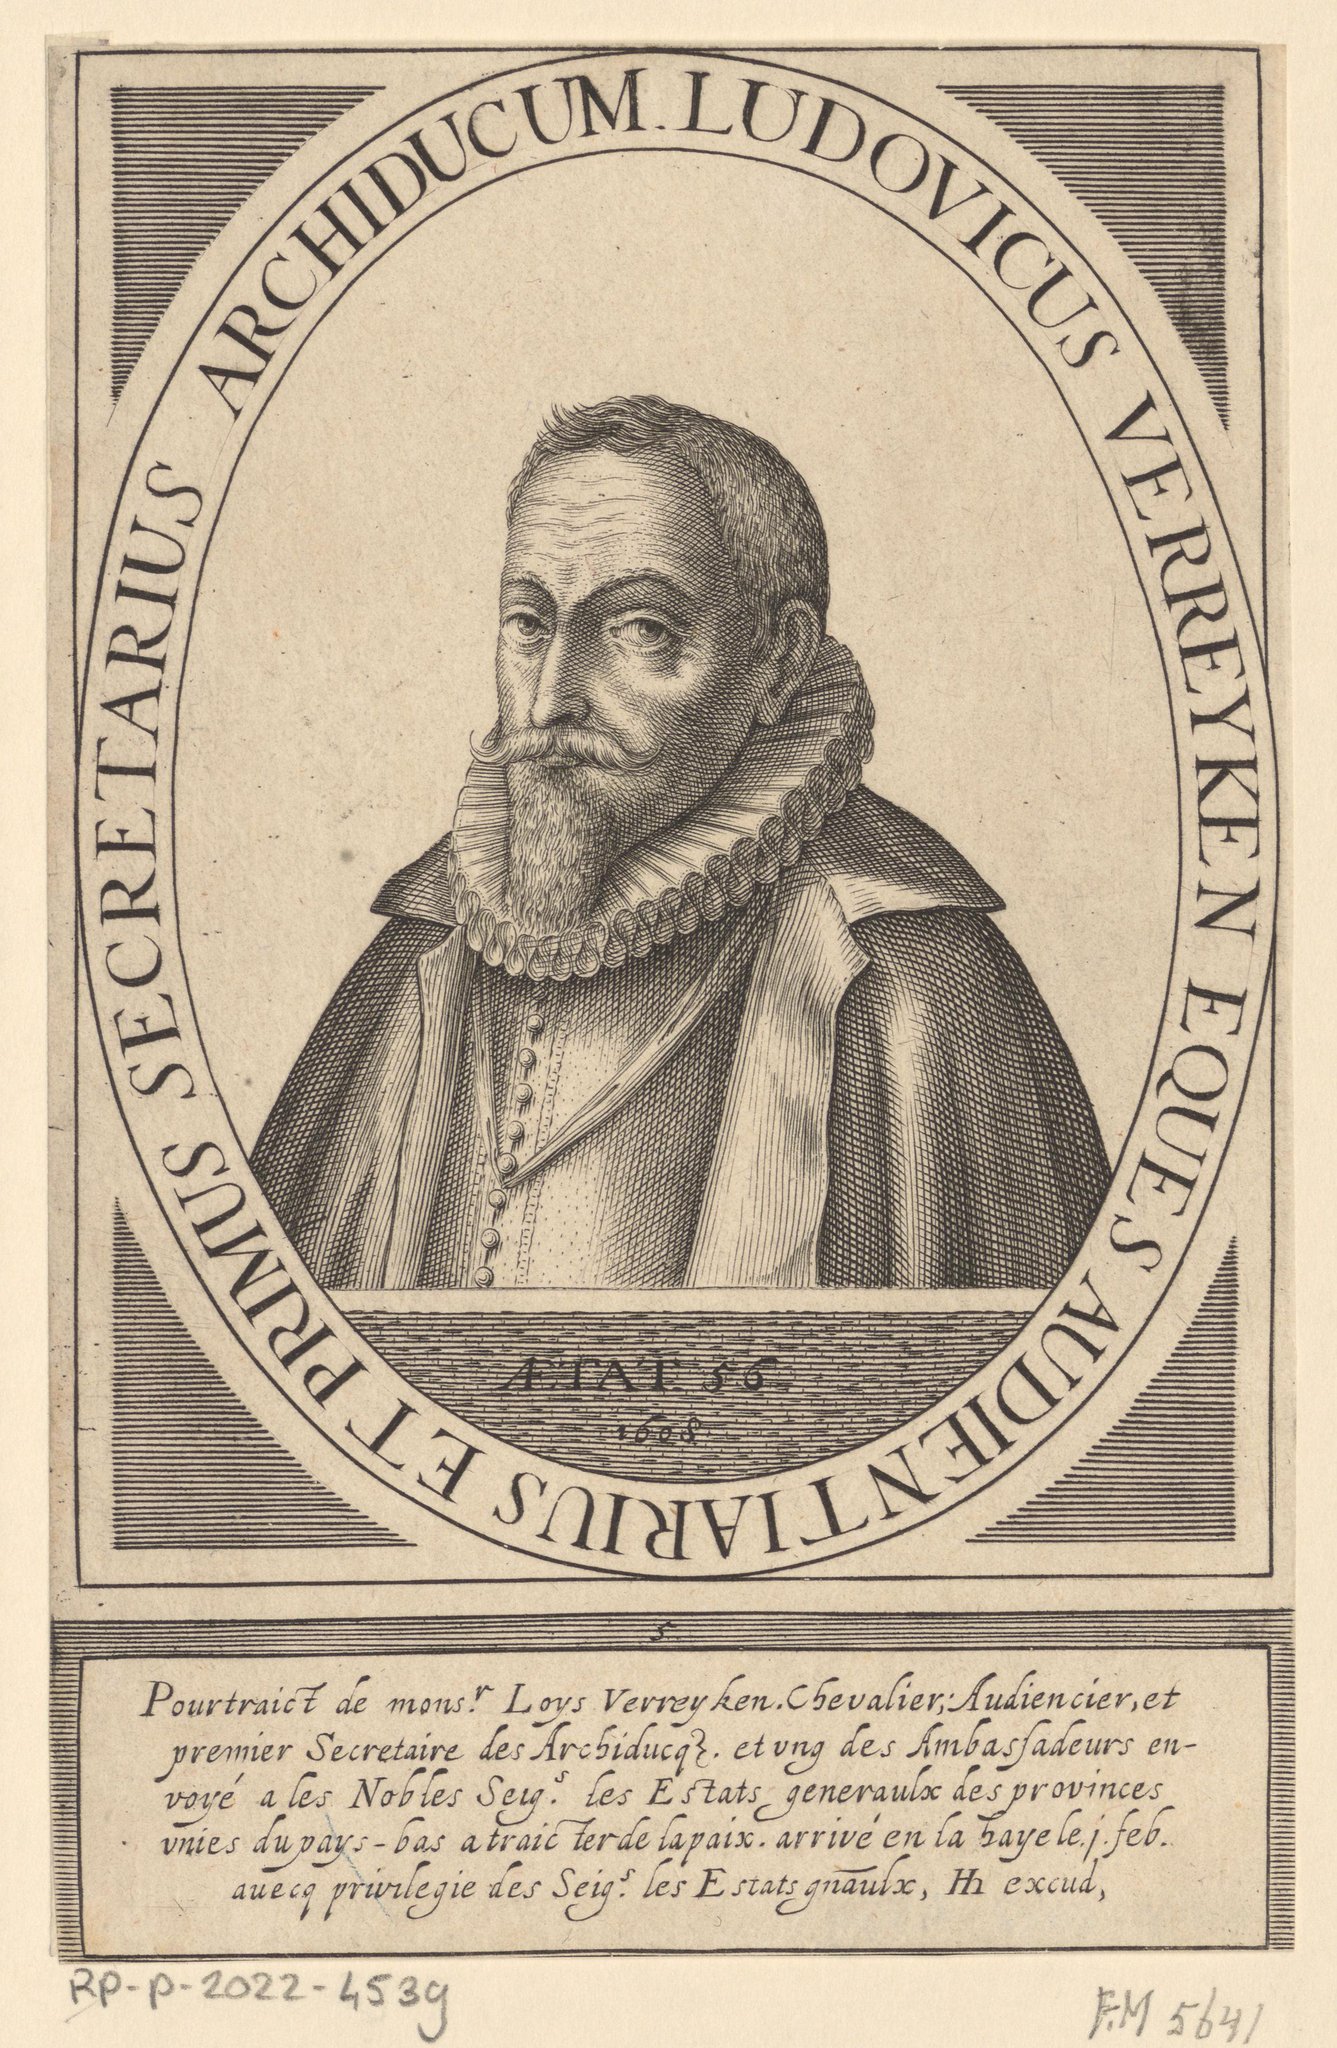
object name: print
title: Portret van Lodewijk Verreyken op 56-jarige leeftijd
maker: hendrick hondius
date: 1608-1609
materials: paper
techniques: engraving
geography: the hague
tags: official; civil servant; functionary (in general), historical persons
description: Genummerd boven het onderschrift: 5. Met vijfregelig onderschrift in het Frans.